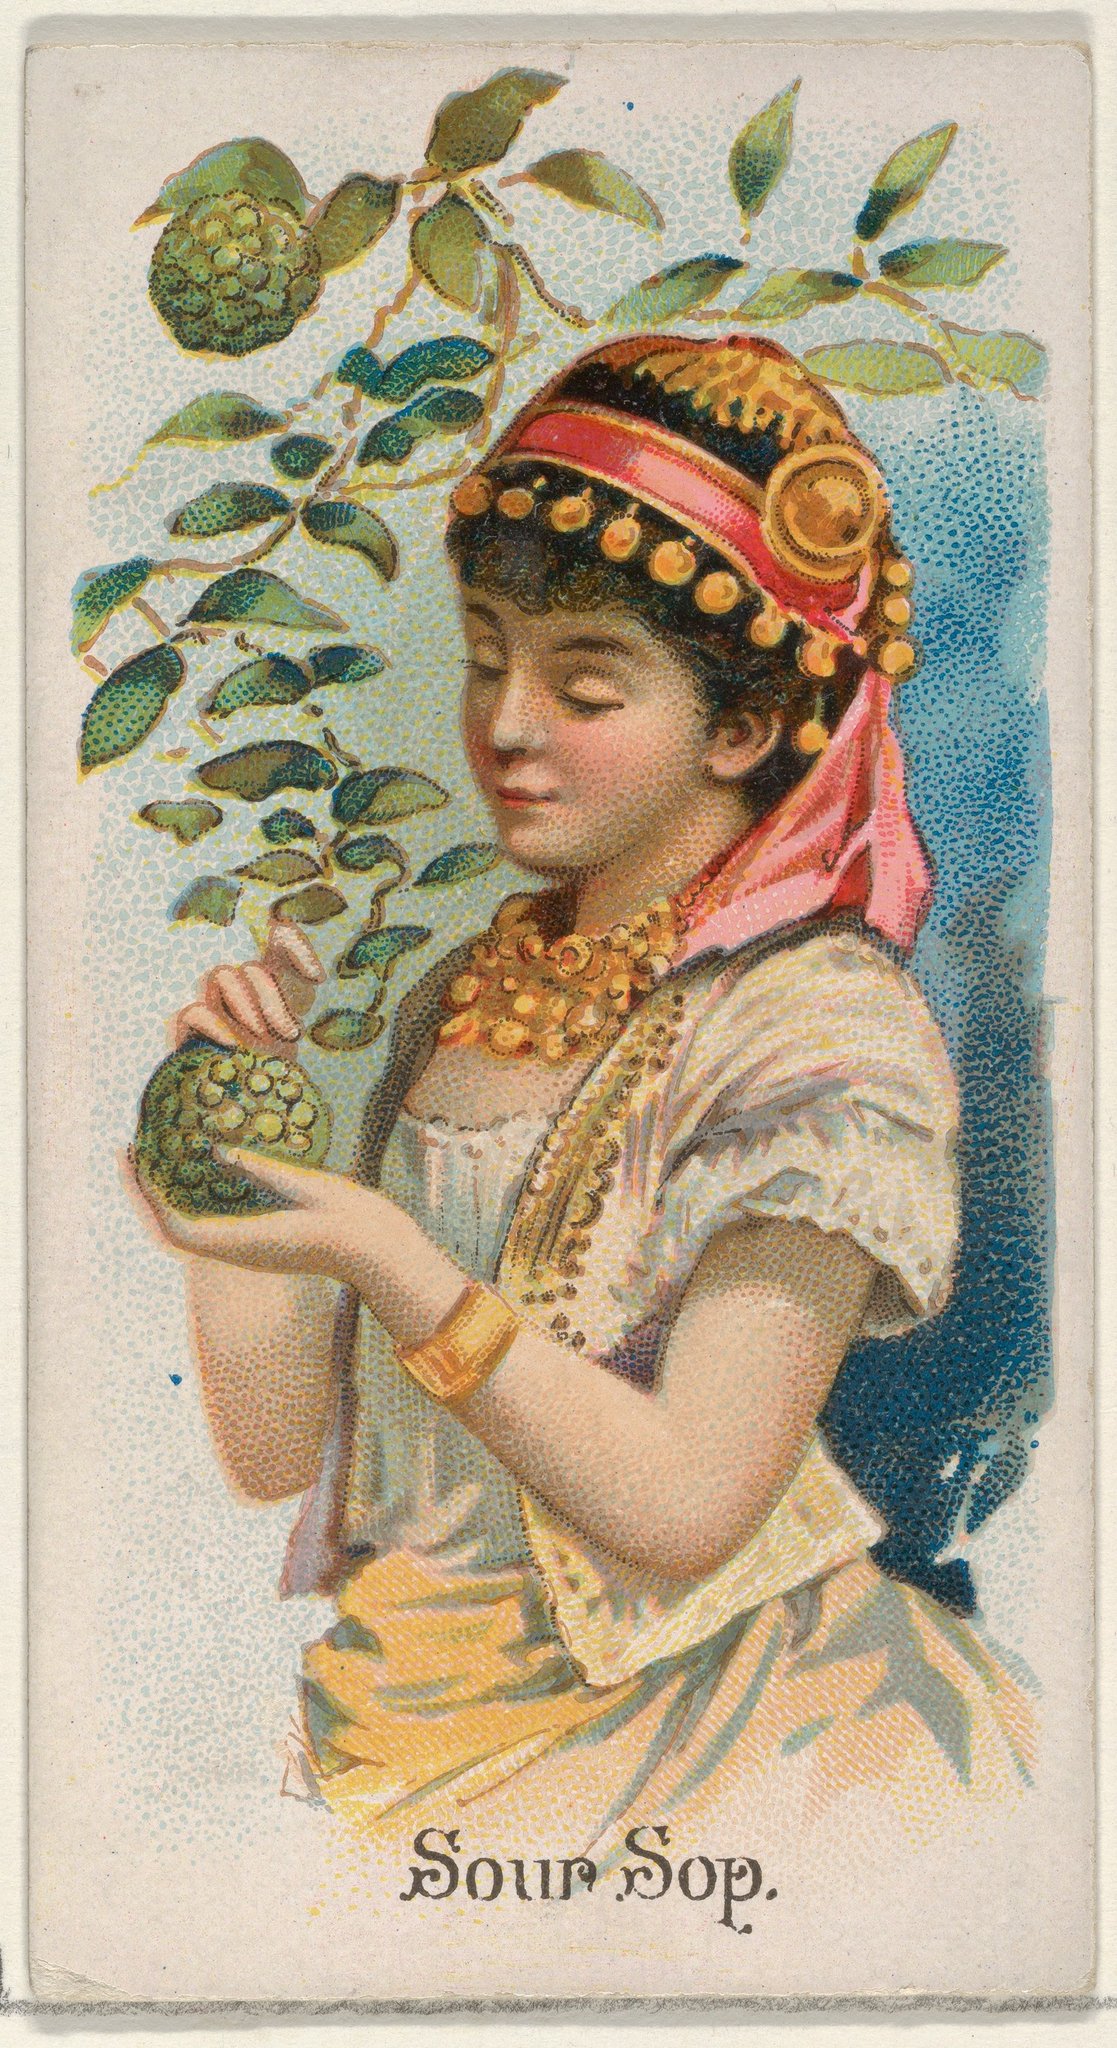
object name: print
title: Sour Sop, from the Fruits series (N12) for Allen & Ginter Cigarettes Brands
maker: allen & ginter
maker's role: publisher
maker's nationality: american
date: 1891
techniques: color lithograph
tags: fruit,women